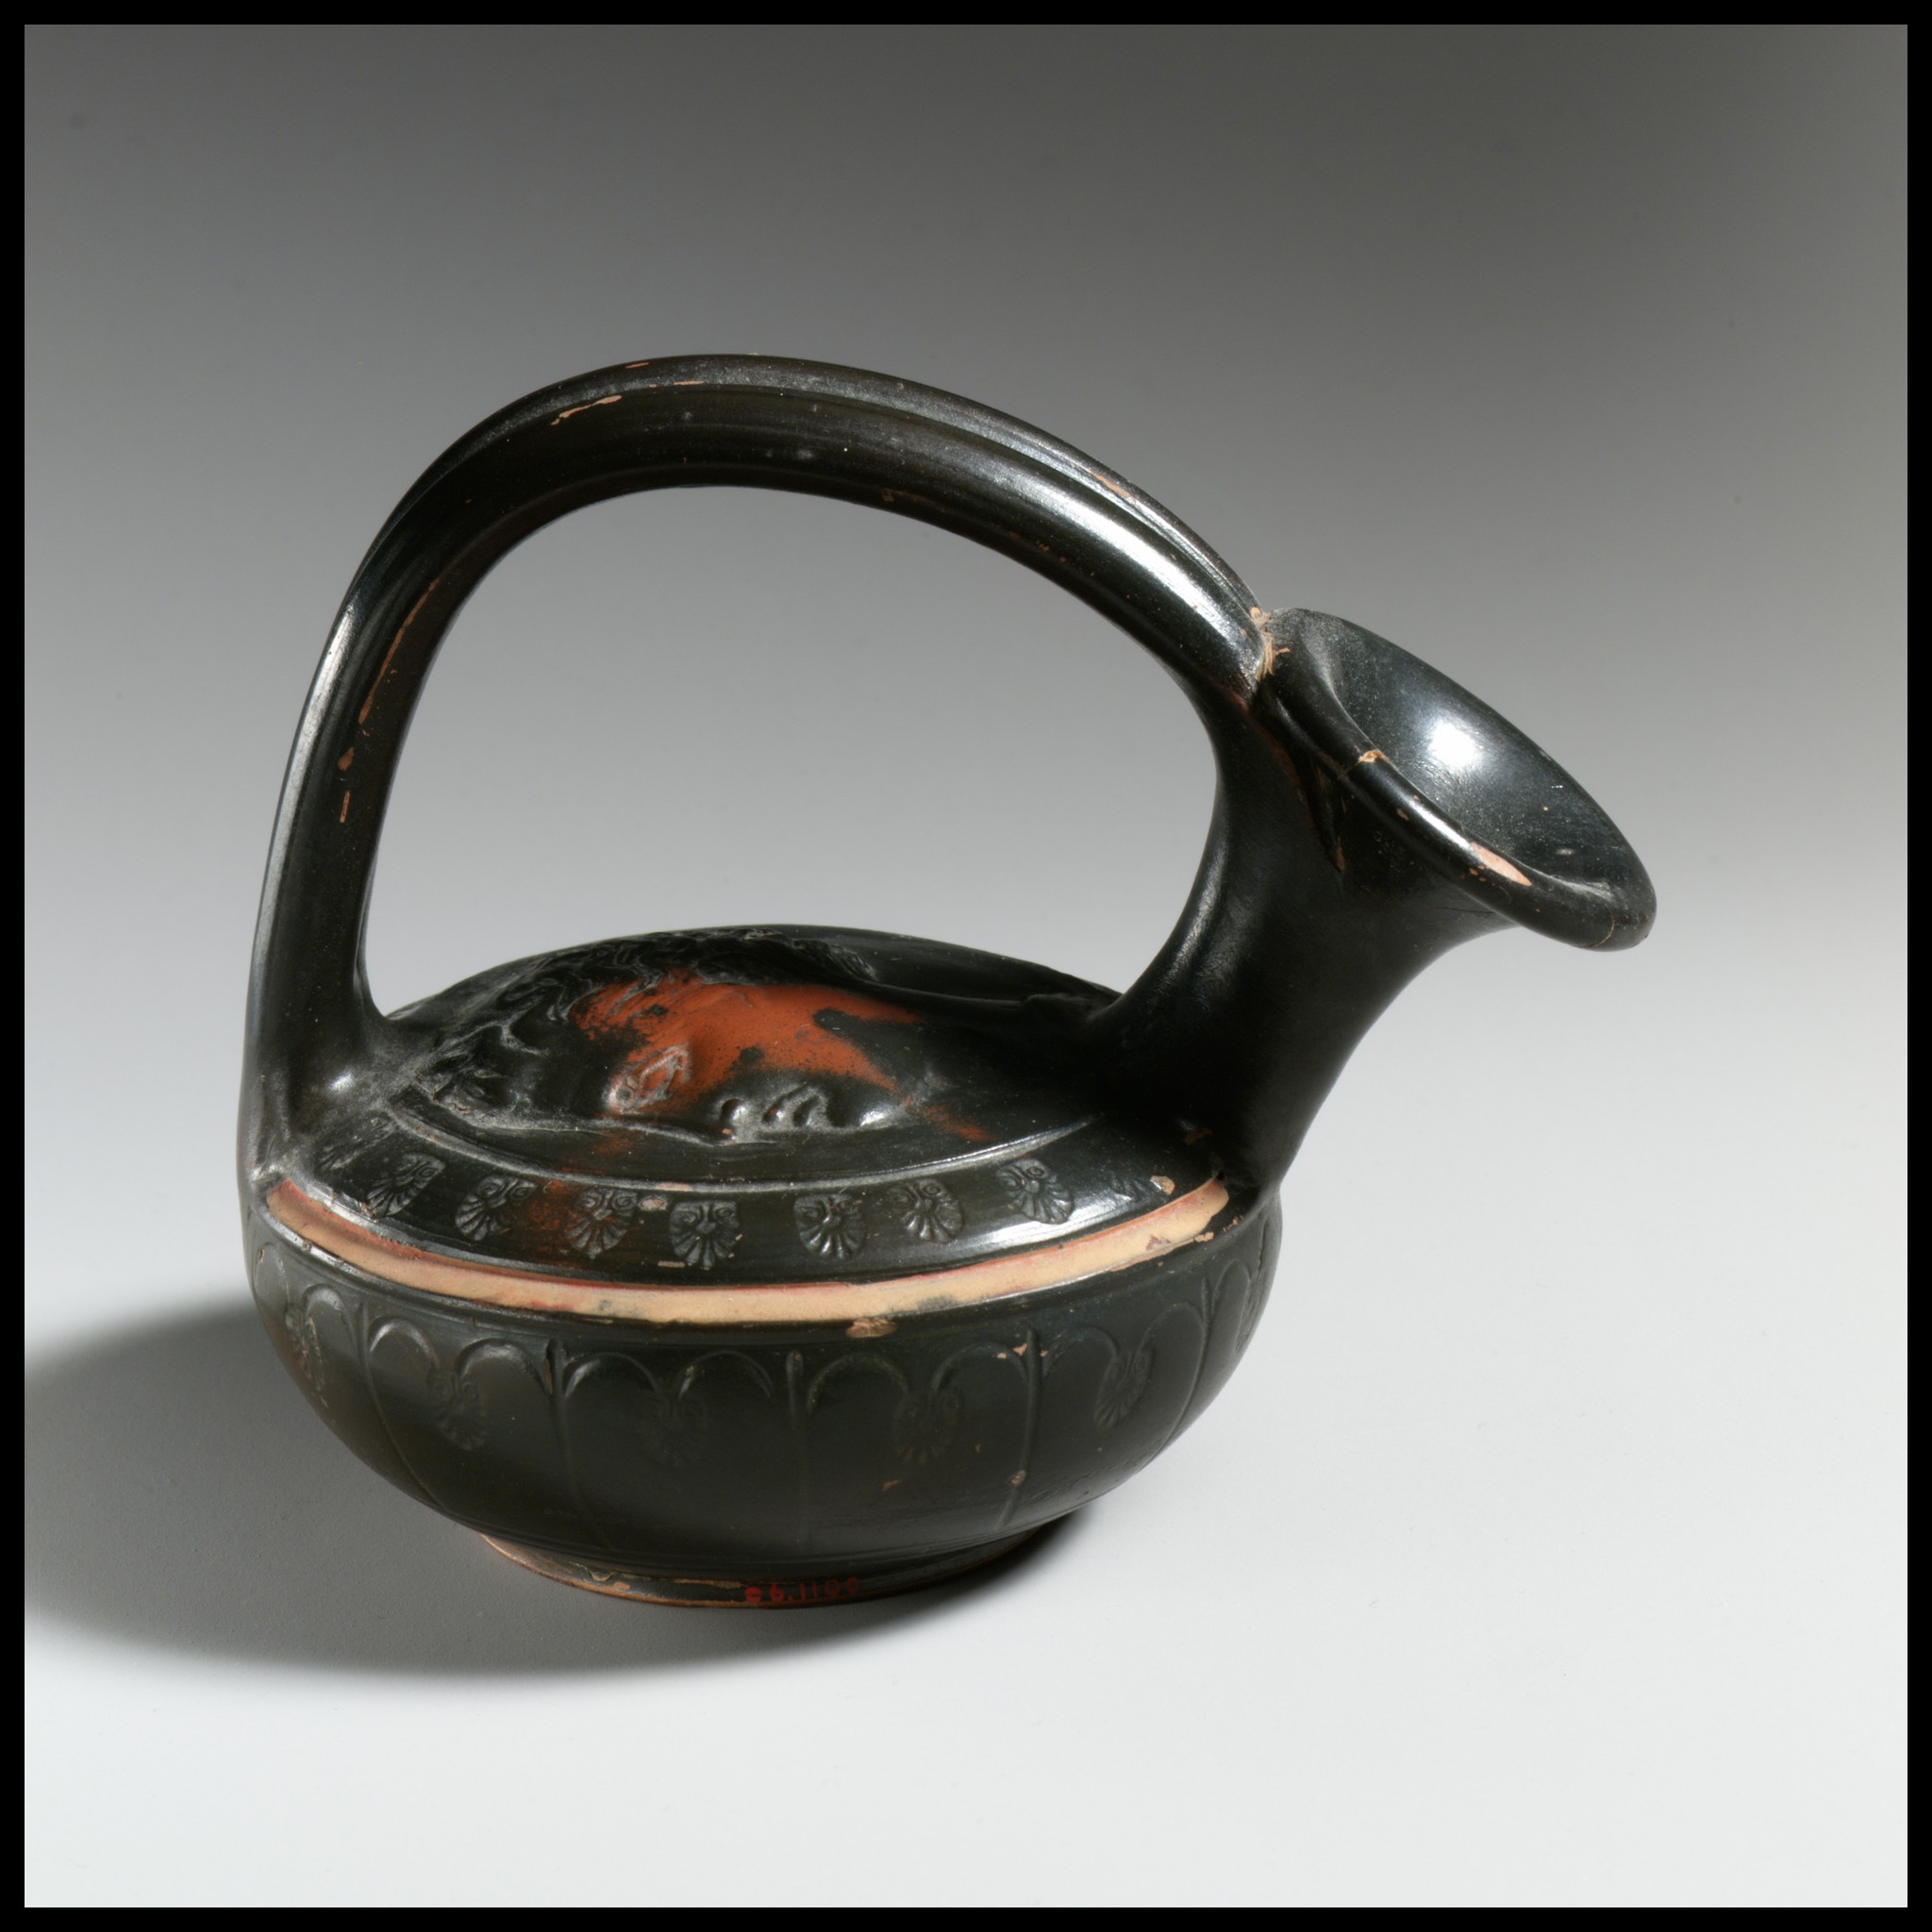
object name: askos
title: Terracotta askos (flask with a spout and handle over the top)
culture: greek or south italian or campanian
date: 334-301 BCE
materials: terracotta